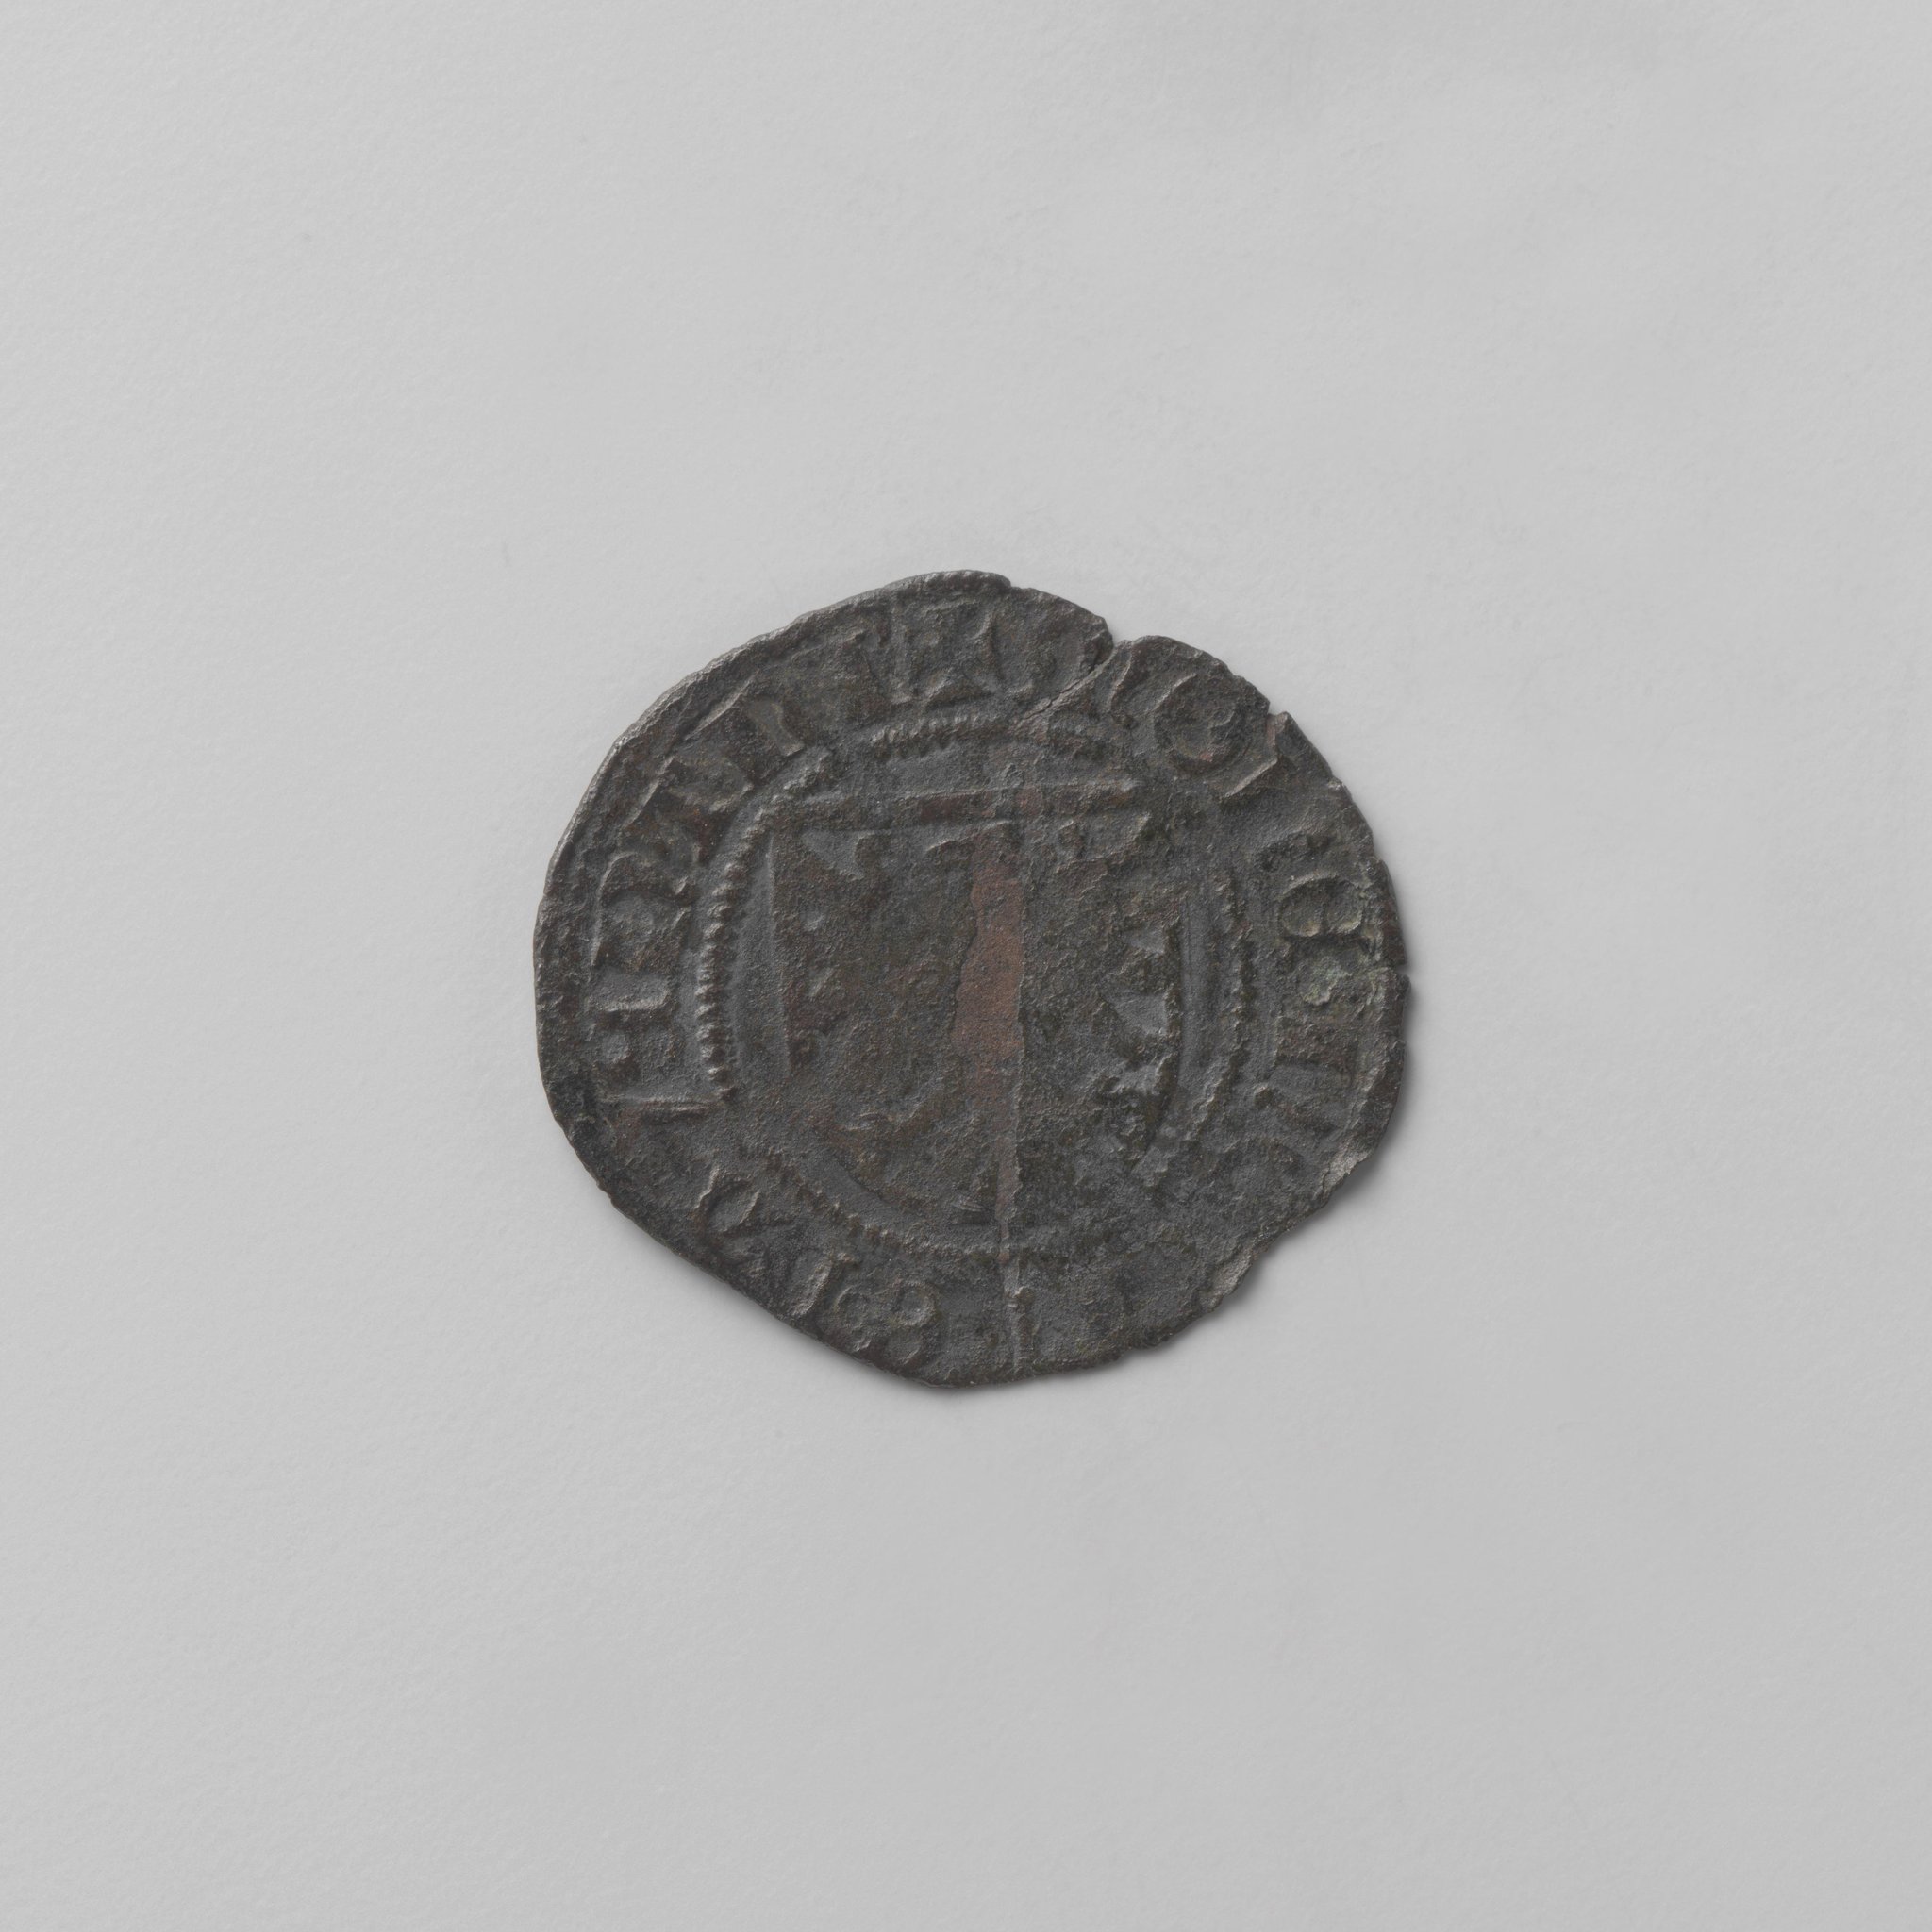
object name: coin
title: Deventer, achtste stuiver, 1523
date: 1523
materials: silver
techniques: striking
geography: deventer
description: Zilveren munt. Voorzijde: wapenschild met enkelkoppige adelaar en wapenschild van het Oversticht. Keerzijde: lang gevoet kruis met in de hoeken letters D, A, V en E. Jaartal in omschrift.